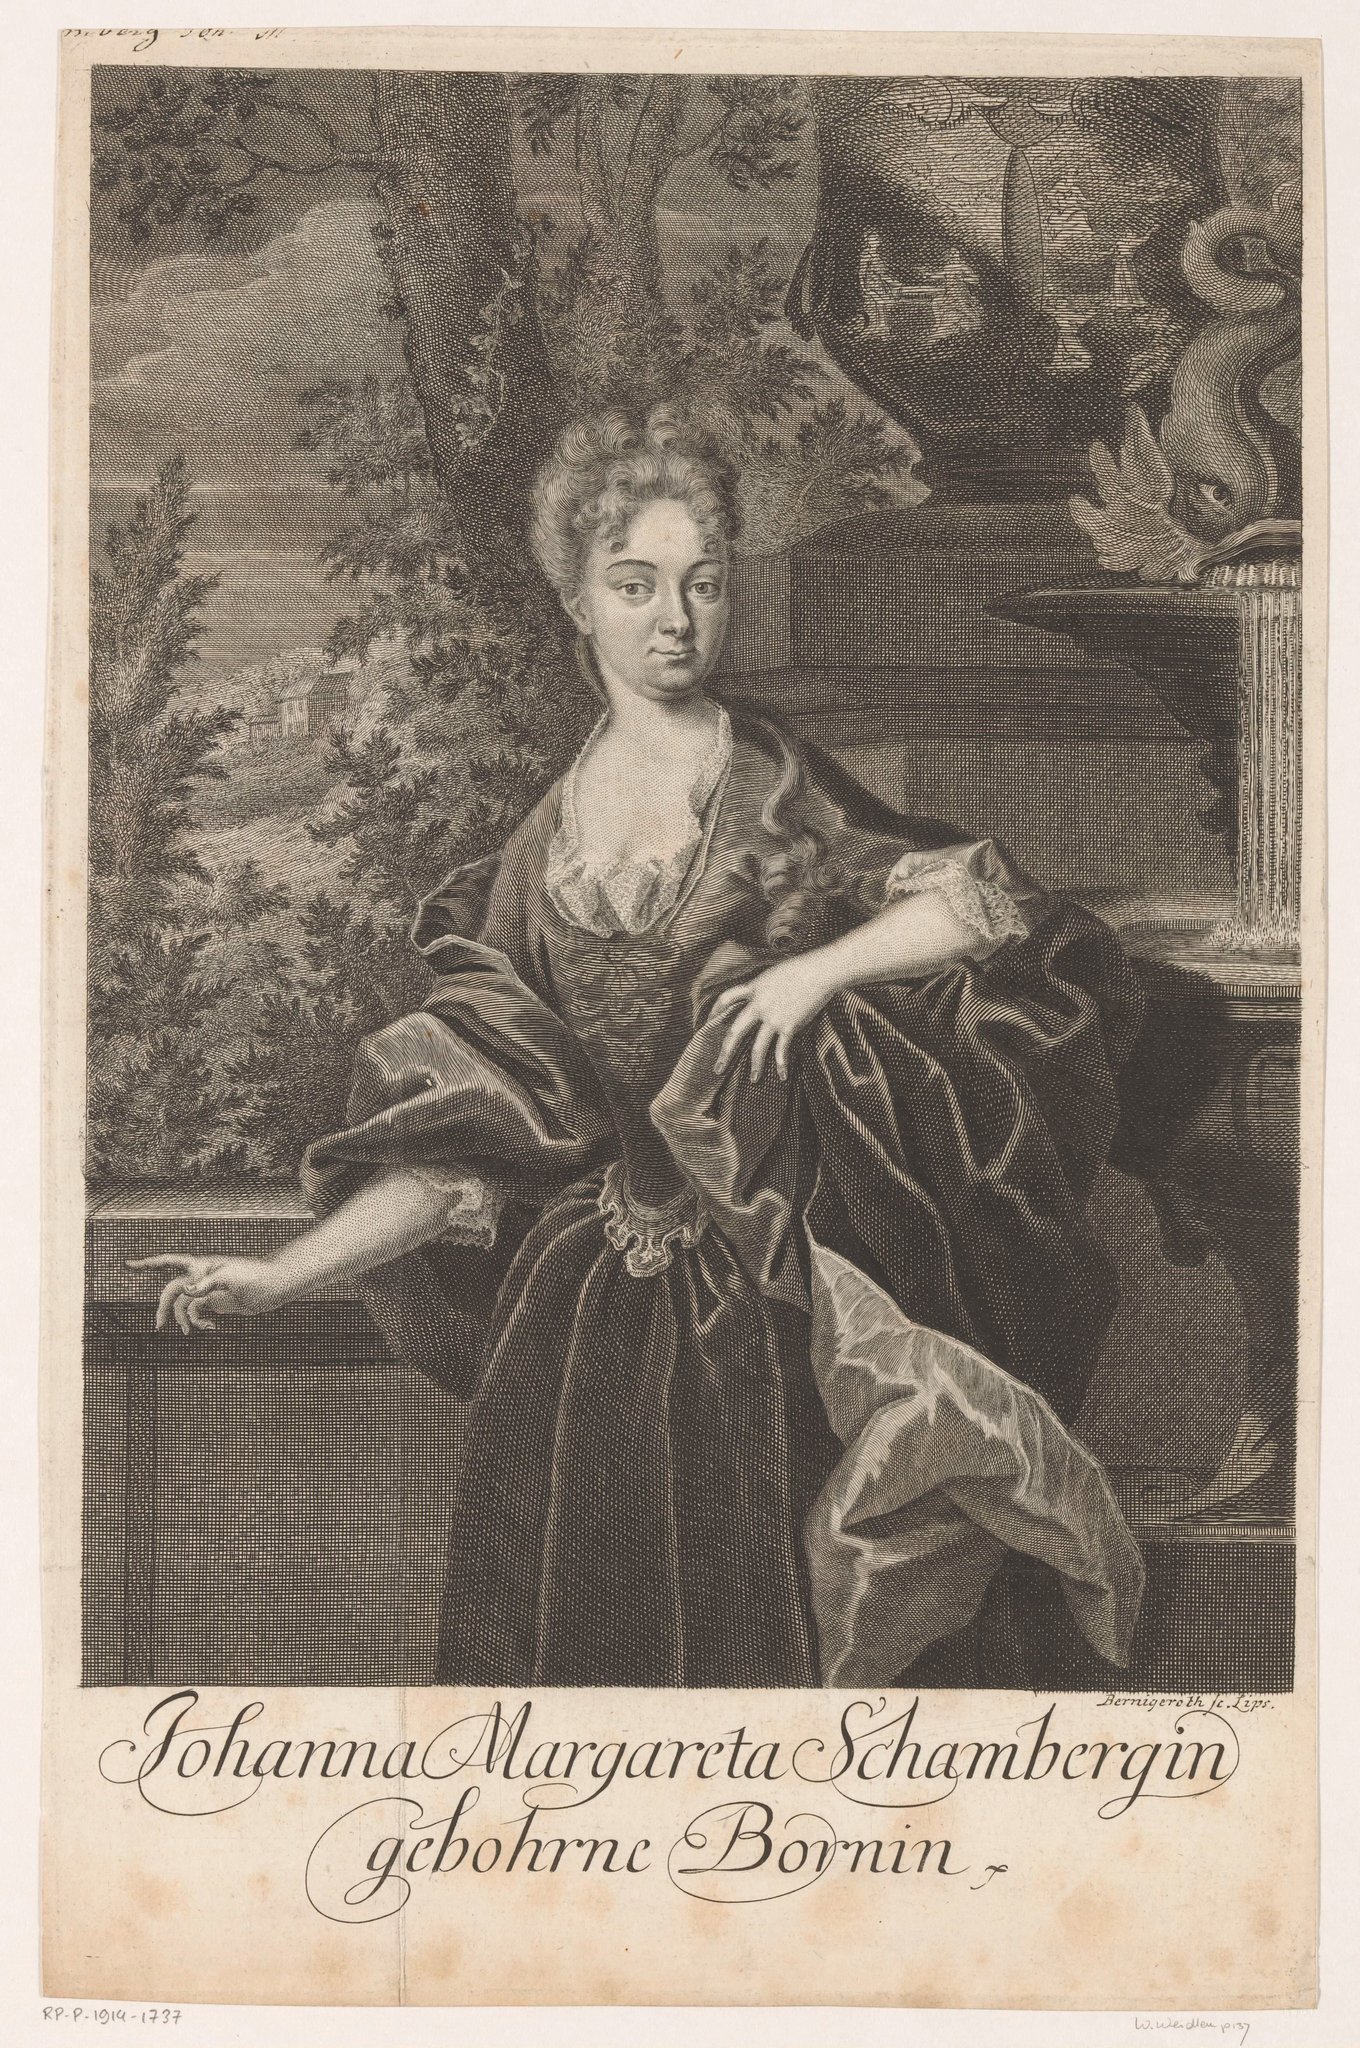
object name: print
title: Portret van Johanna Margaretha Schamberg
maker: martin bernigeroth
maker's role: print maker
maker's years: 1670-1733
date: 1720-1733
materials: paper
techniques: engraving, etching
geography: leipzig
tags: historical persons - bb - woman, garden fountain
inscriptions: collector's mark: Lugt 2228